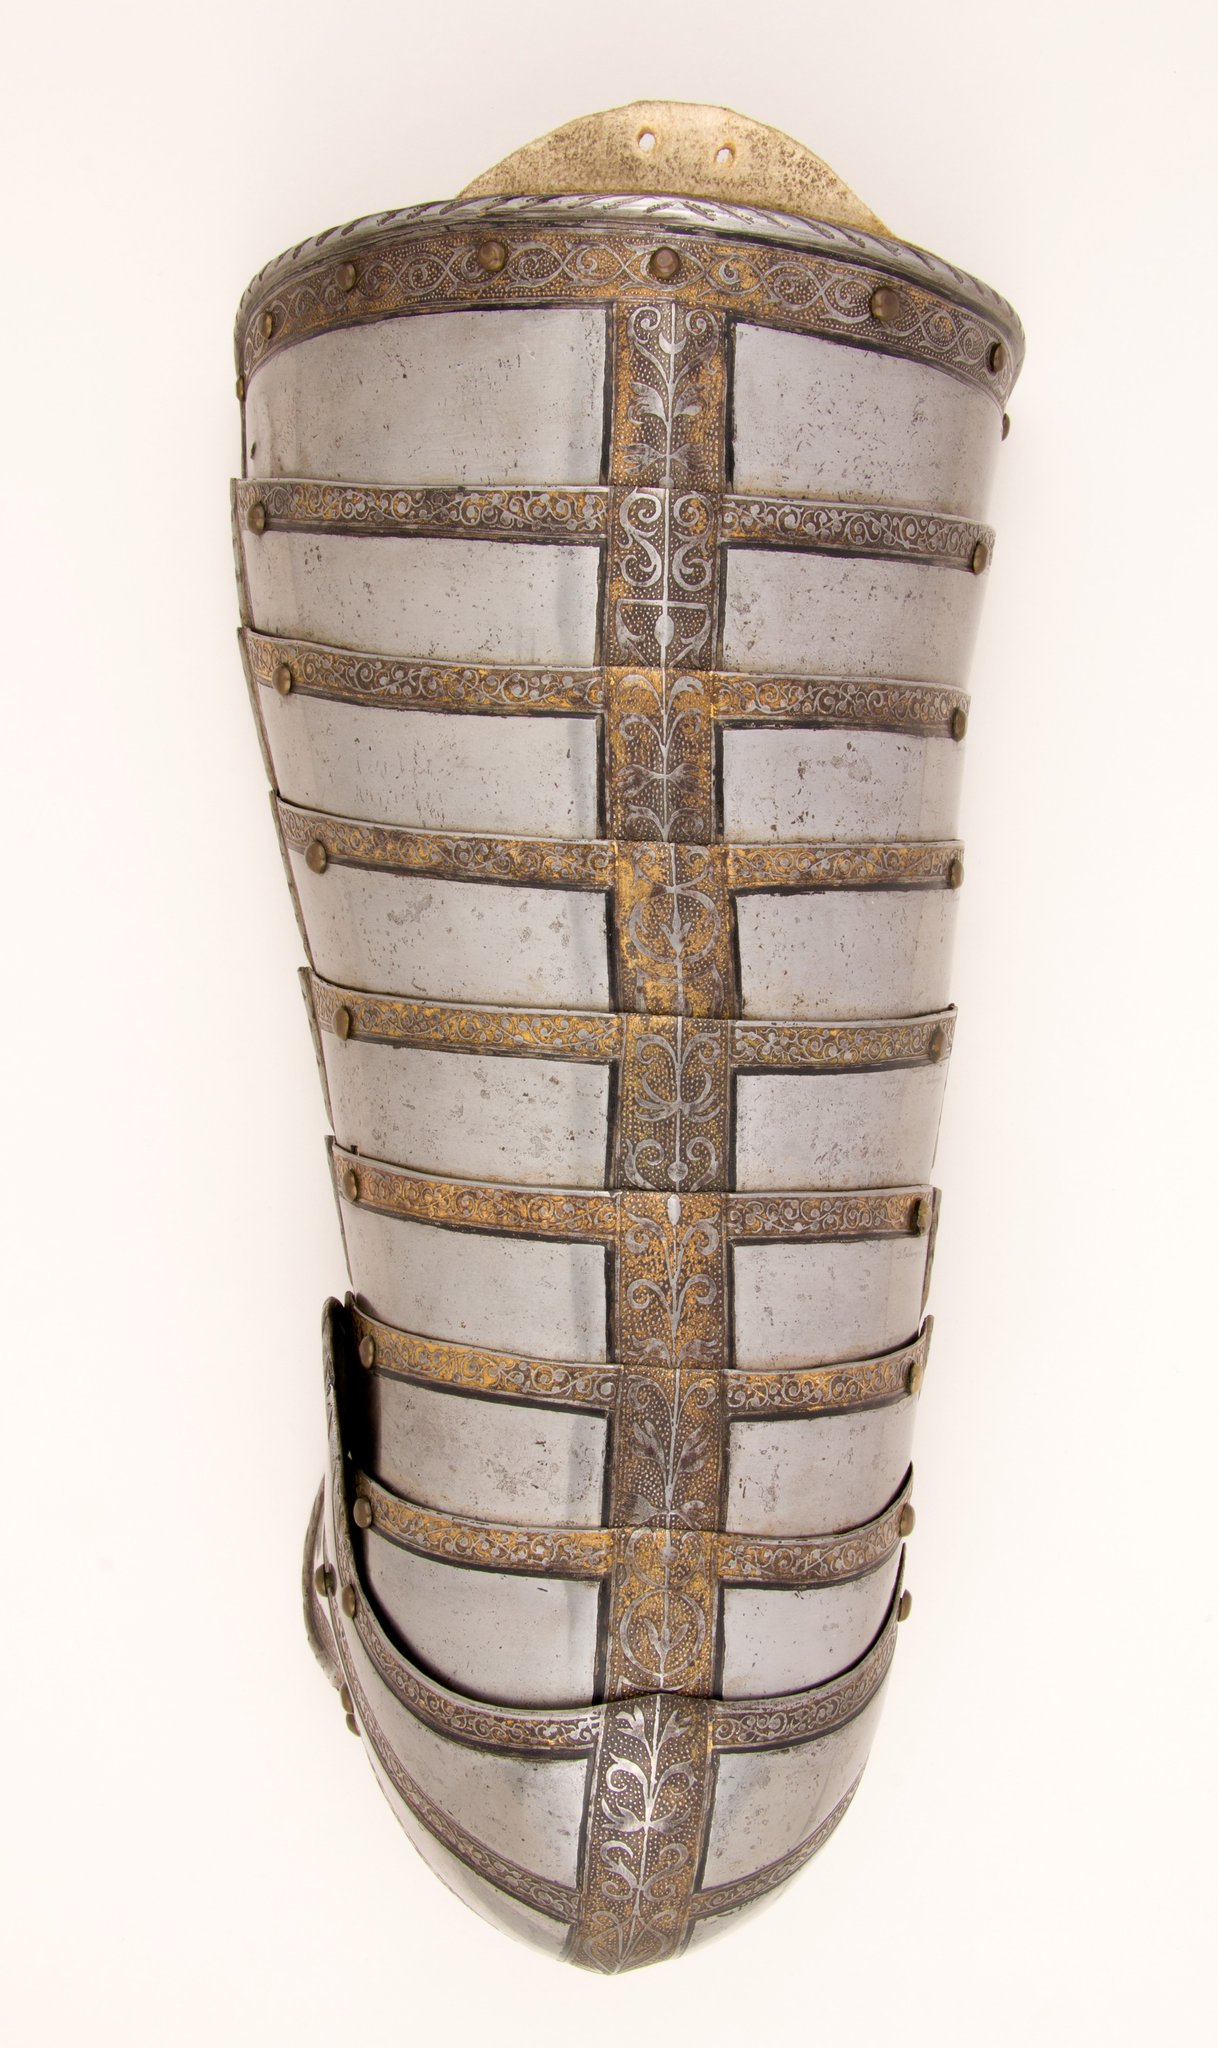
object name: pair of thigh defense cuisse with knee defense poleyns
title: Right Thigh and Knee Defense (Cuisse and Poleyn) for the Armor of Sir John Scudamore (1541 or 1542–1623)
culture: american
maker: daniel tachaux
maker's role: armorer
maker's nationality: french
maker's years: 1857-1928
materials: gold, leather, steel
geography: united states